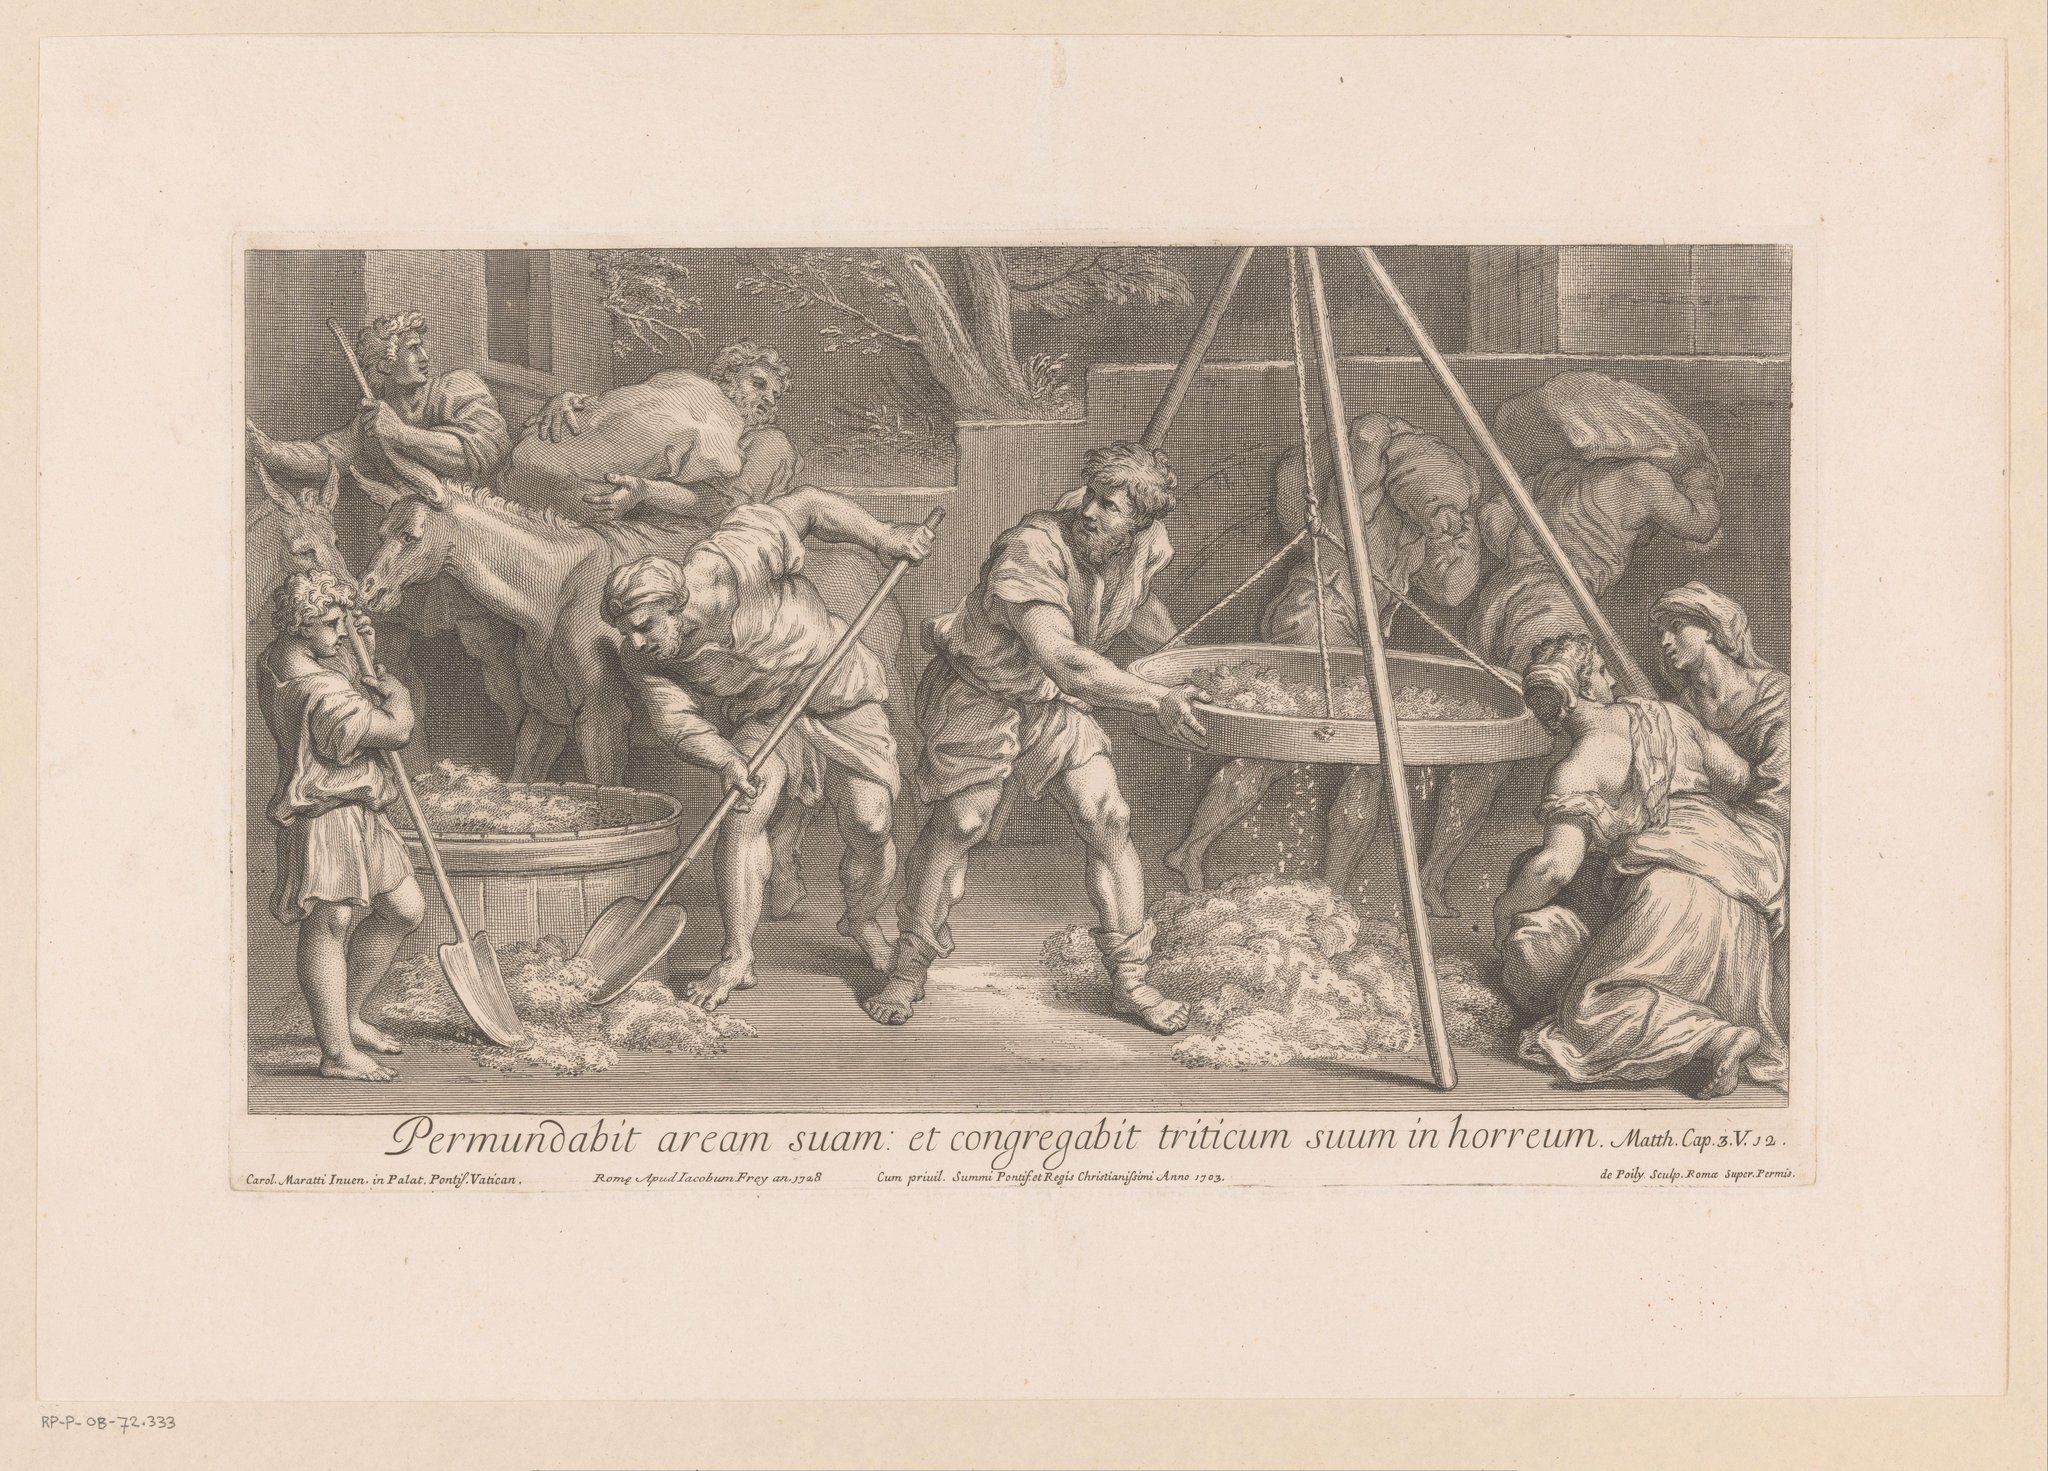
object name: print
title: Arbeiders bezig met de verwerking van graan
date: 1703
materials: paper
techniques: engraving, etching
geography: rome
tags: harvest, winnowing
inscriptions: collector's mark: Lugt 240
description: Groep mannen en vrouwen die graan schept, zeeft en vervoert in zakken en op ezels.